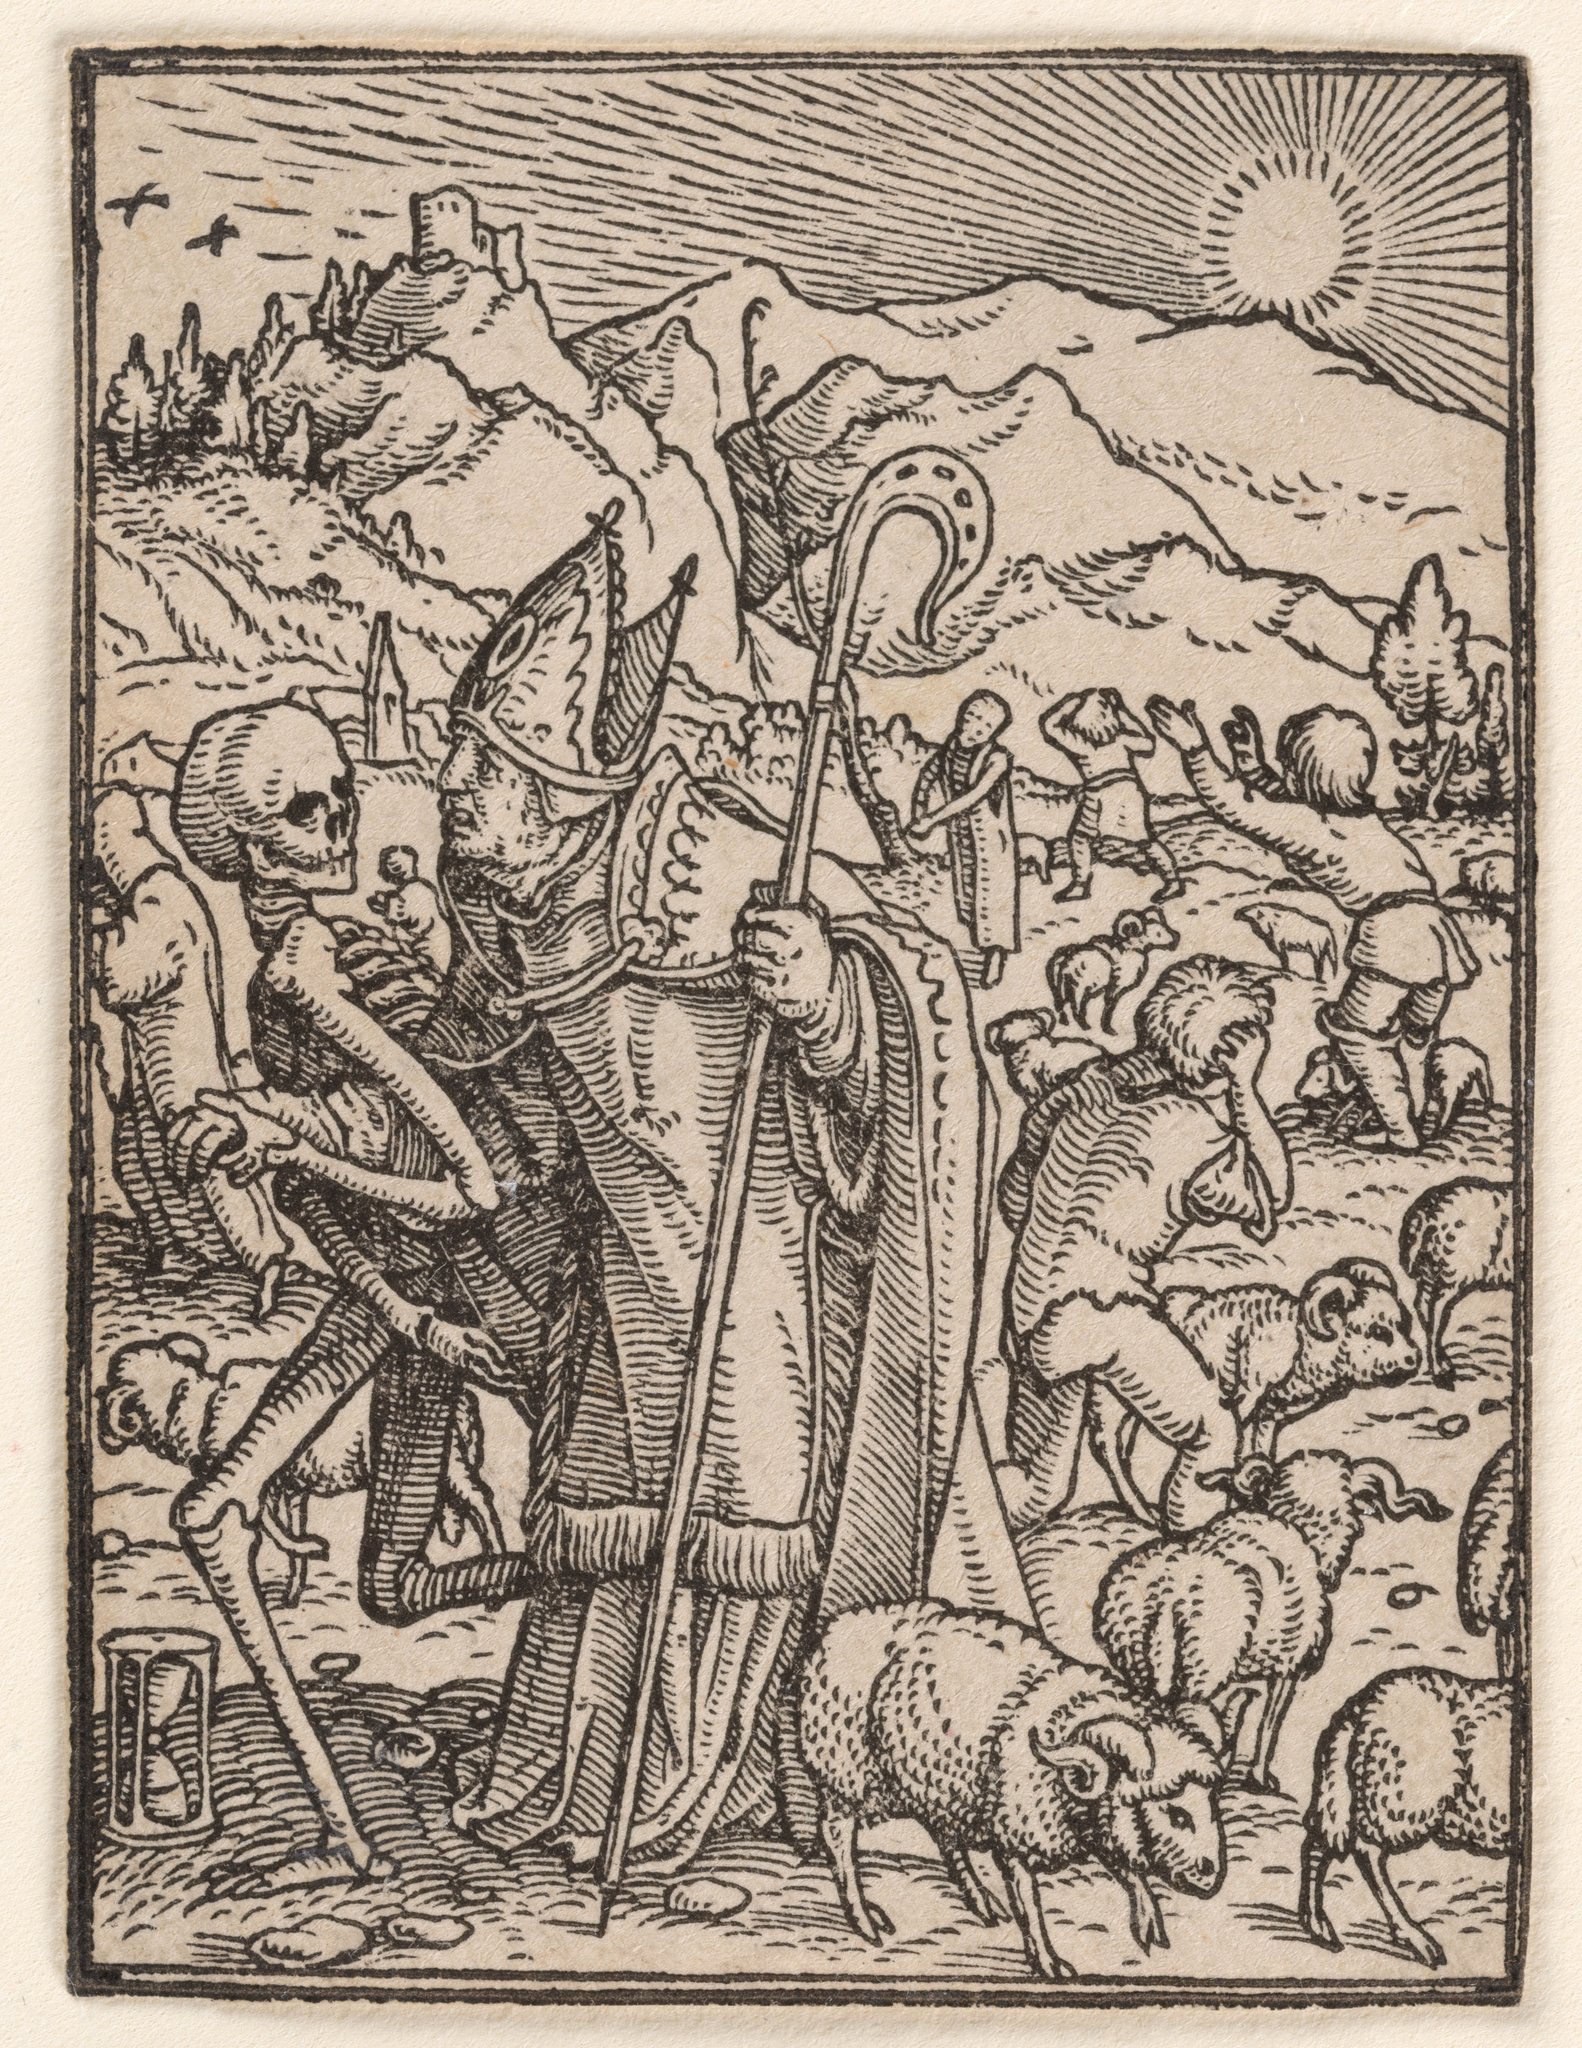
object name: print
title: The Bishop, from "The Dance of Death"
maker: hans holbein the younger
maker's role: artist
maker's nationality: german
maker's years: 1497-1543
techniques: woodcut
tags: skeletons,men,sheep